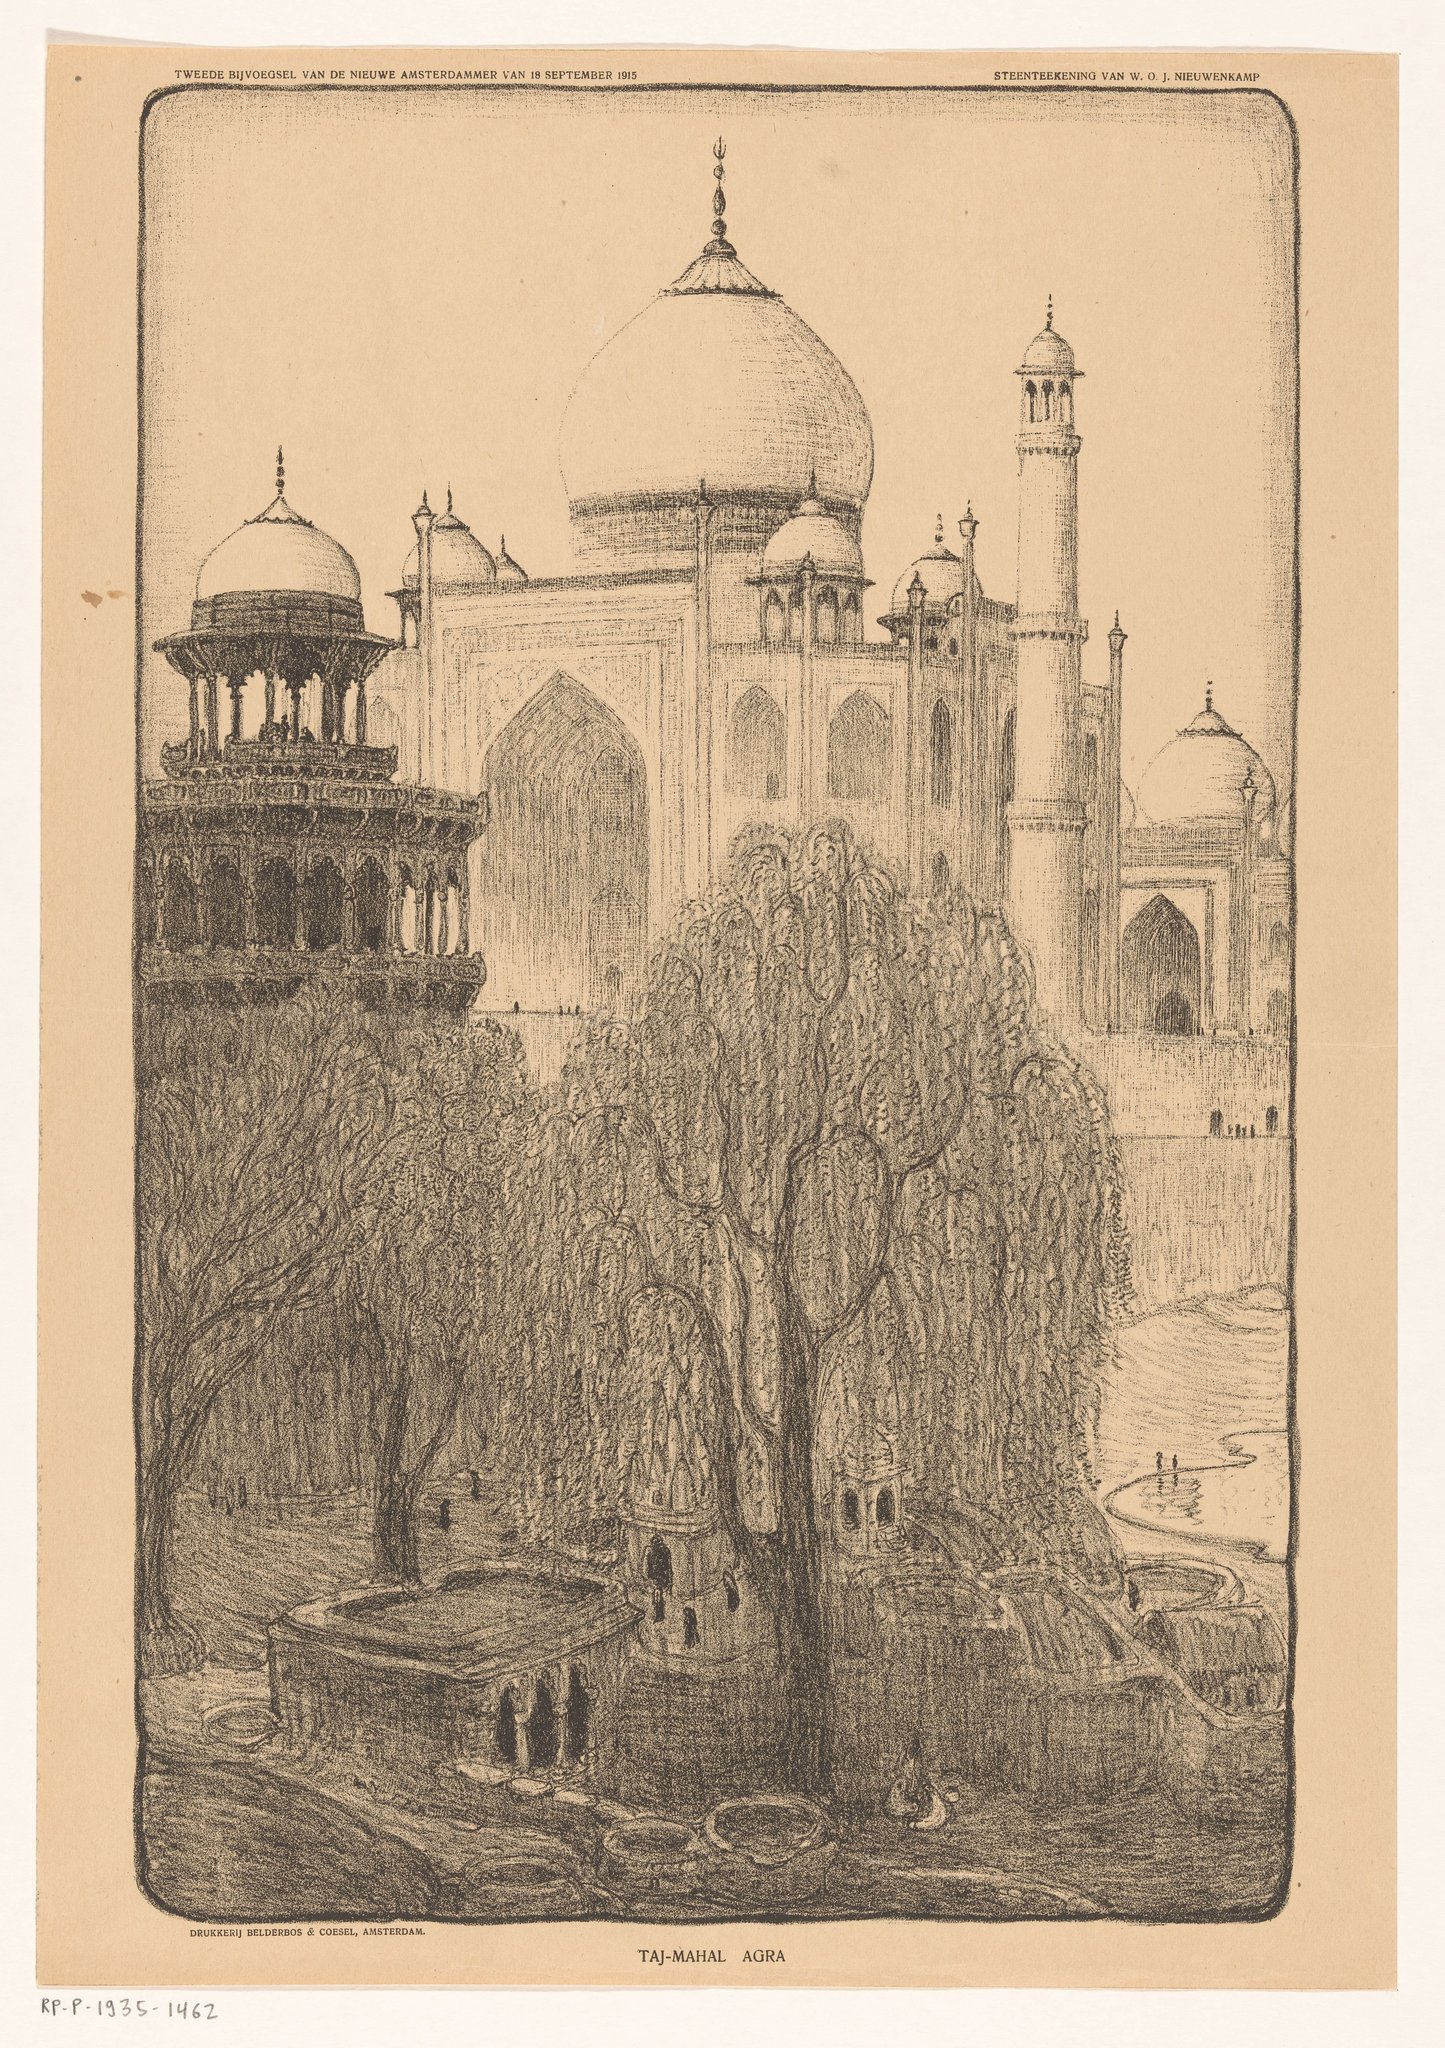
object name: print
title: Taj Mahal, Agra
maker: wijnand otto jan nieuwenkamp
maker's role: draughtsman, print maker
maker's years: 1874-1950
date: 1915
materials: paper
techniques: lithograph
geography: amsterdam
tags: mausoleum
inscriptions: collector's mark: Lugt 2166, collector's mark: Lugt 2760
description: Prent gebruikt voor: De nieuwe Amsterdammer, Onafhankelijk Nederlandsch weekblad. Amsterdam: Maatschappij voor Goede en Goedkope Lectuur, 18 september 1913.